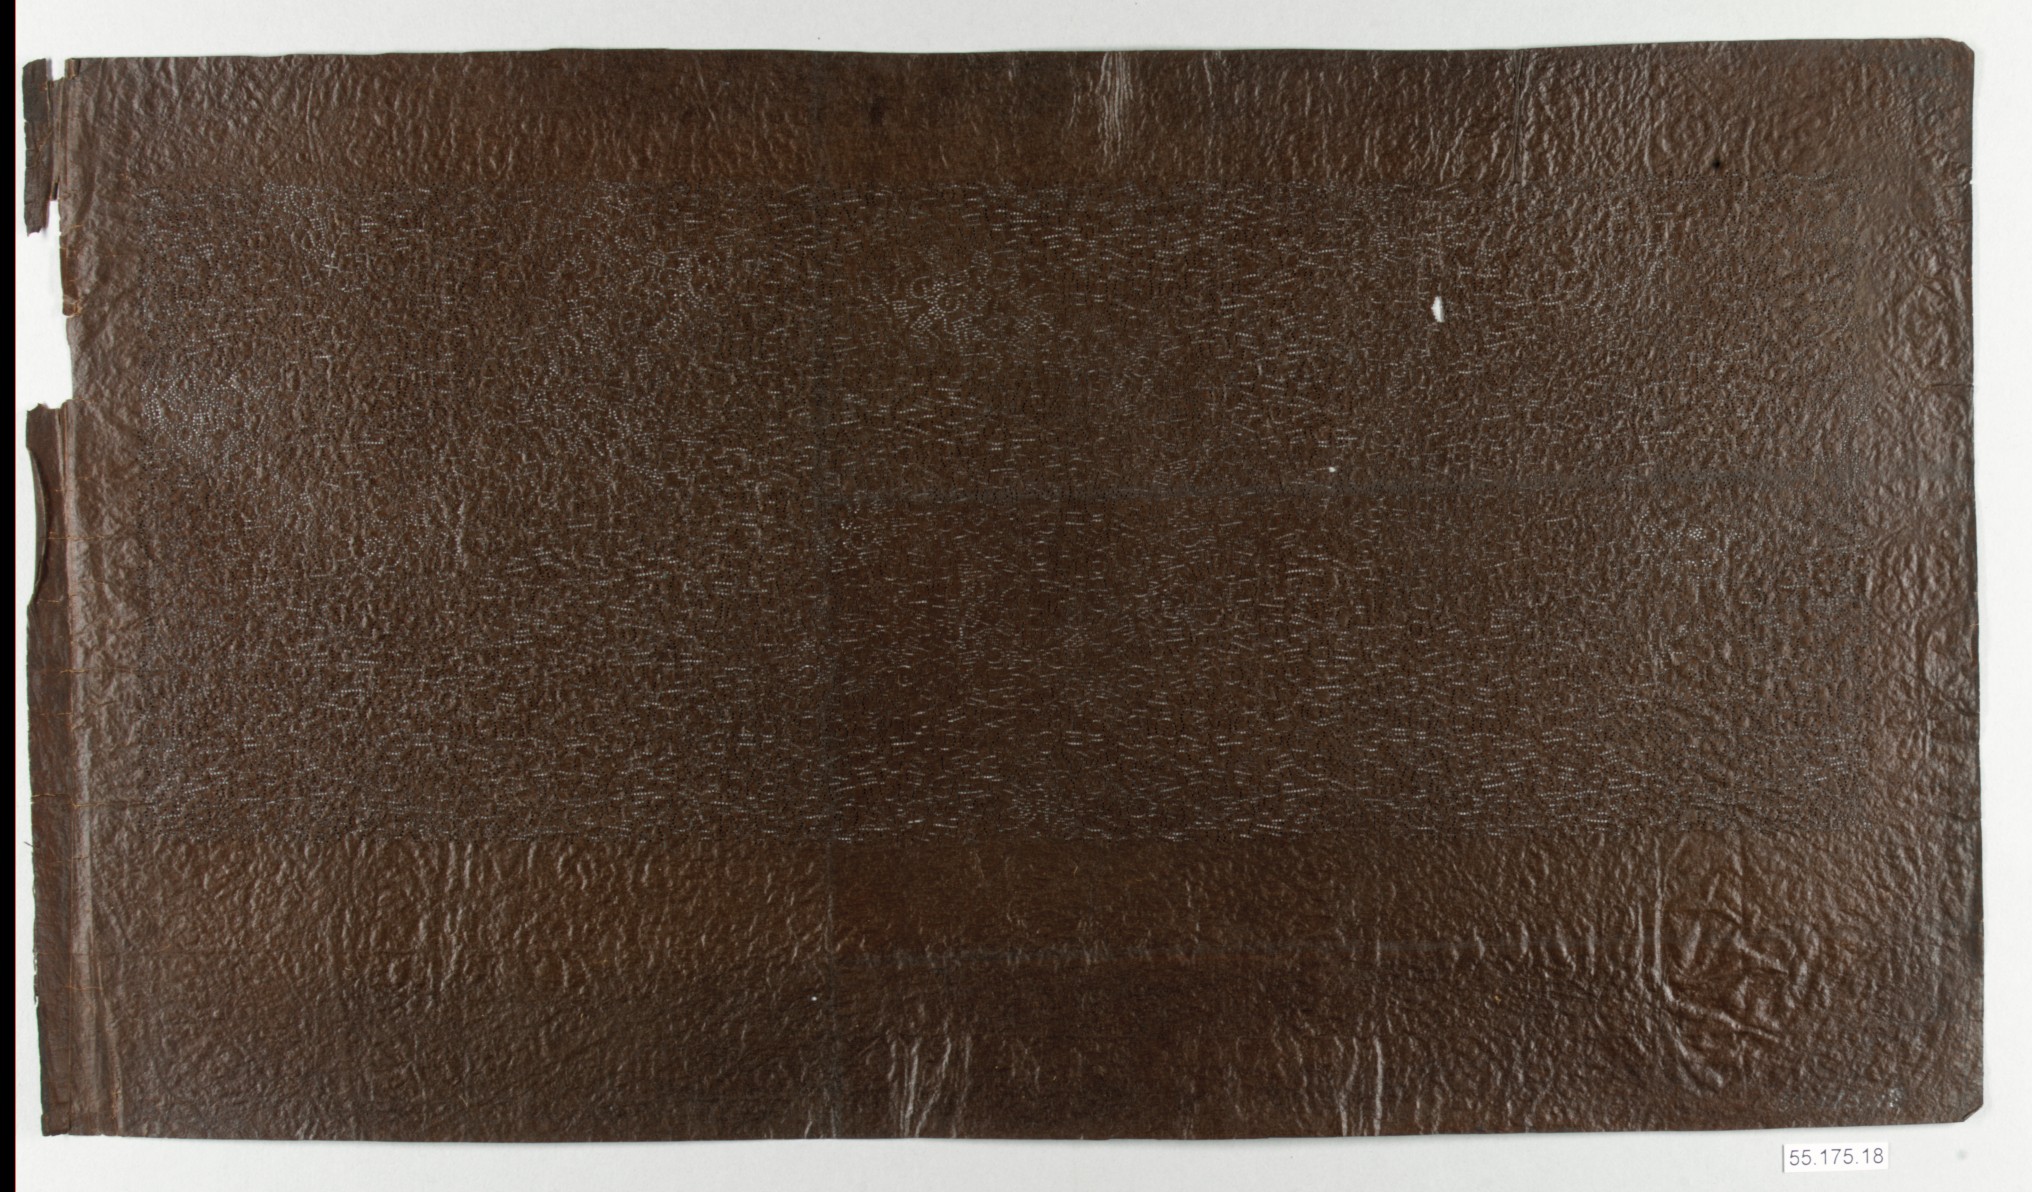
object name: stencil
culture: japanese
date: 1801-1900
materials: paper